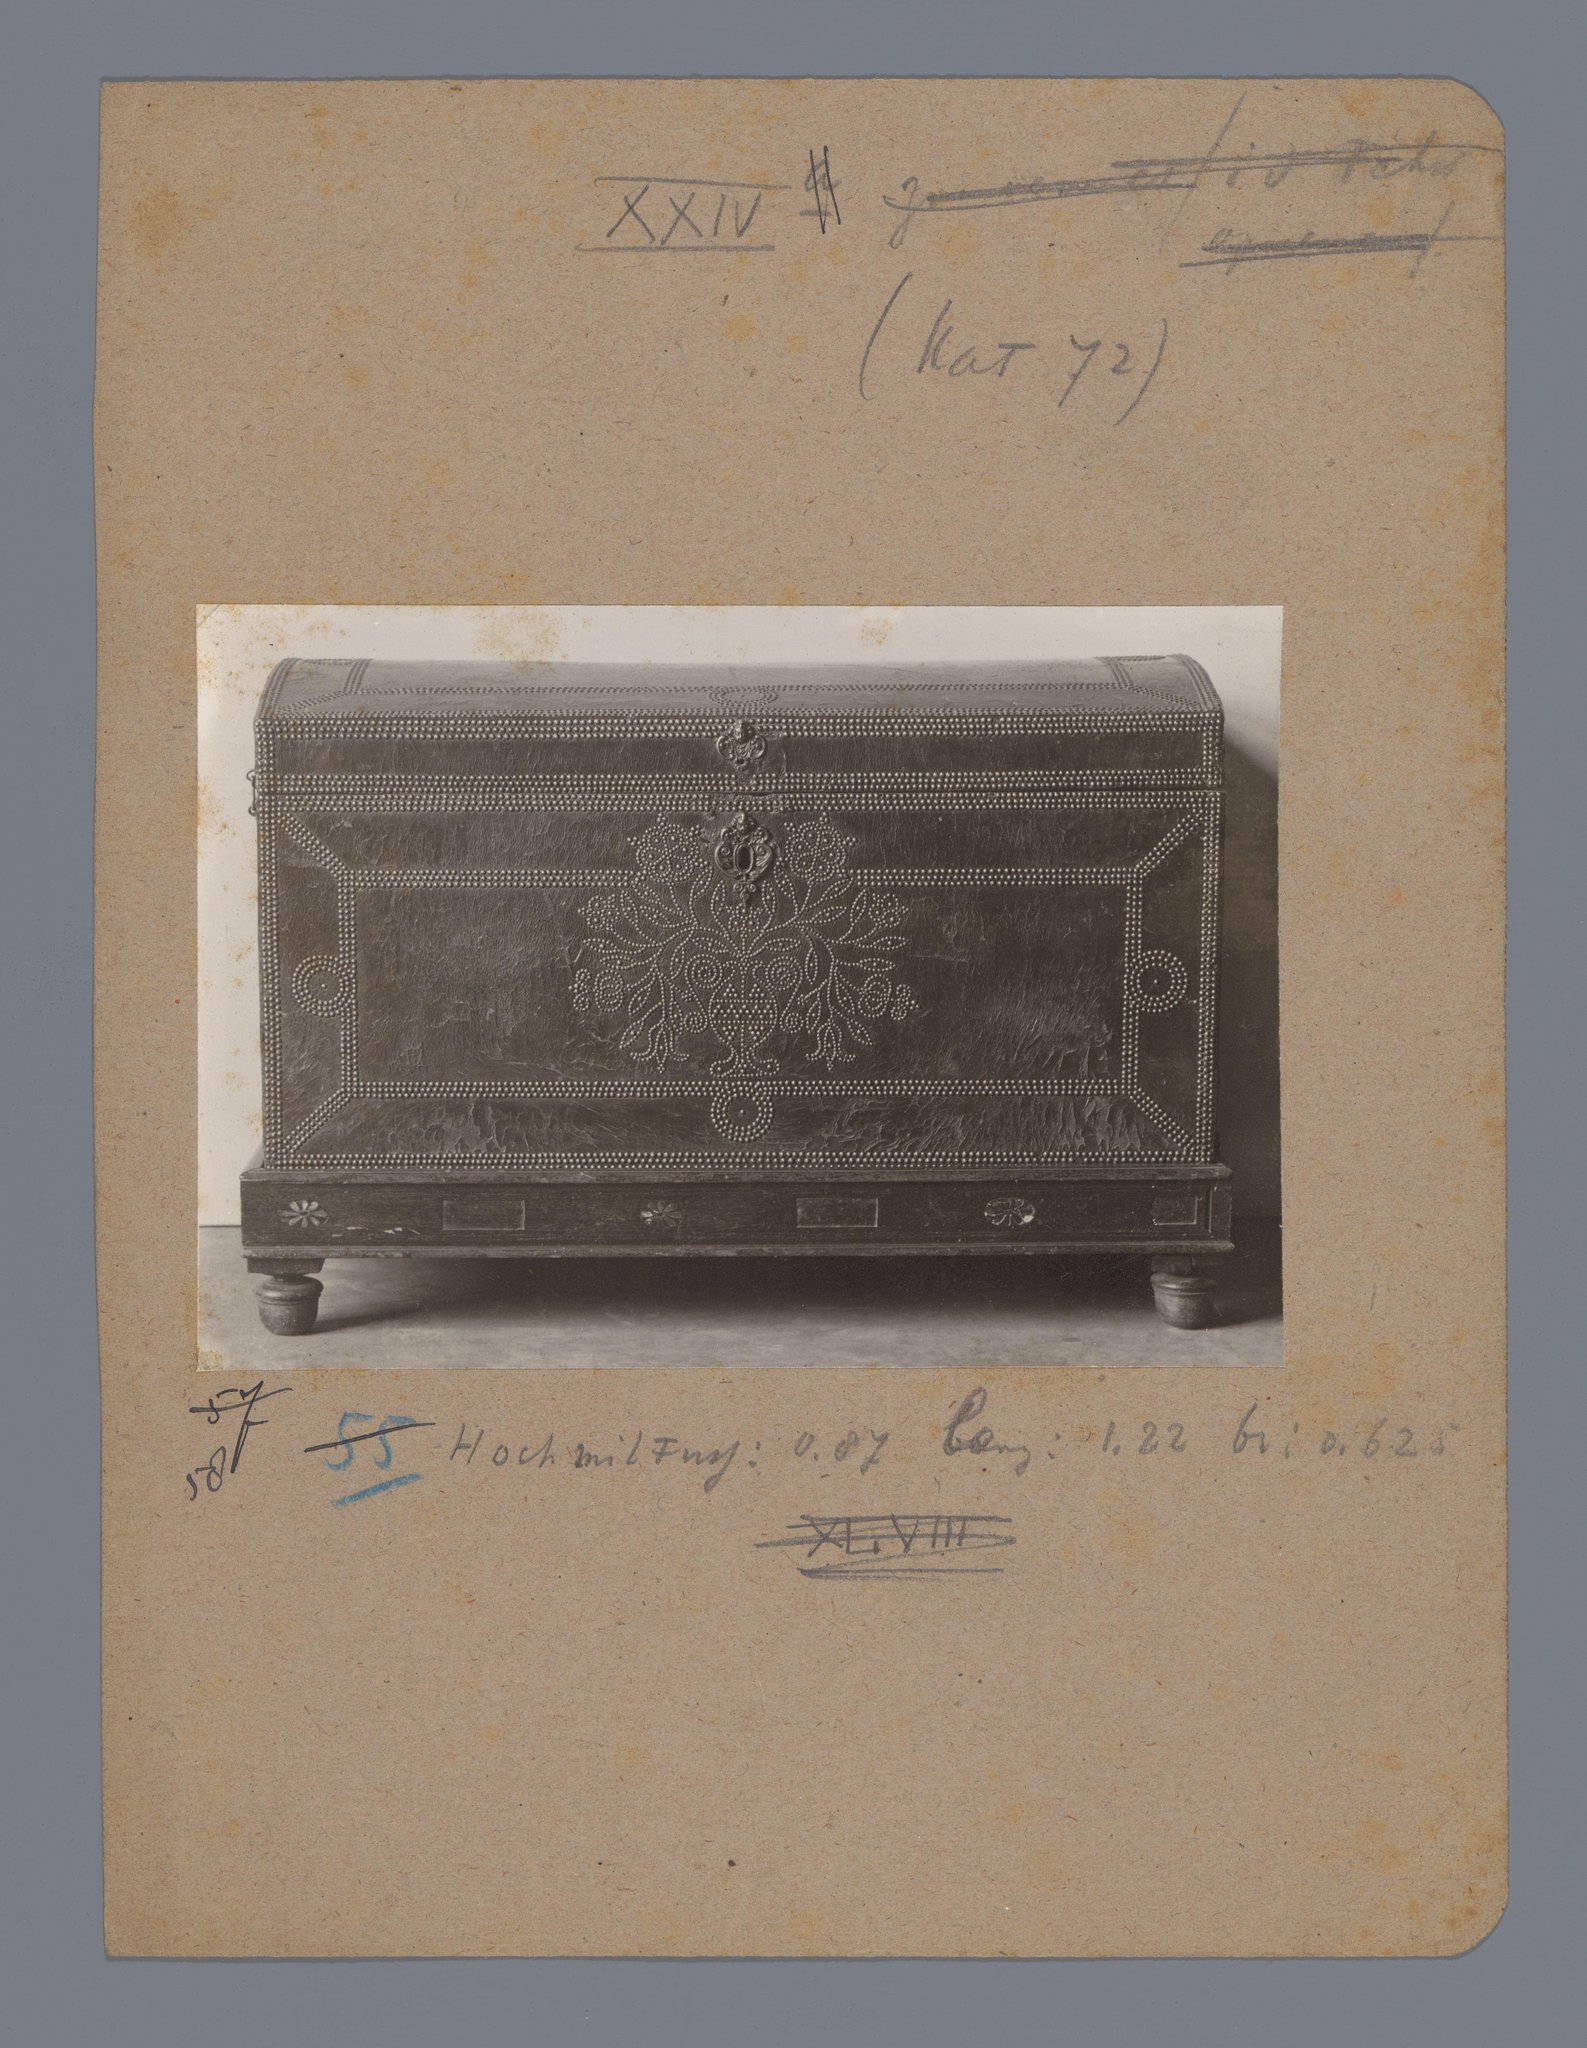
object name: photograph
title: Kist met bloemmotief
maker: Anonymous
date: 1875-1900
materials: paper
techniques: carbon print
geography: netherlands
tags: chest, coffer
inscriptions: collector's mark: ‘Kunstnijverheidschool Quellinus Amsterdam Frans Halsstraat 14.’, collector's mark: ‘Instituut voor kunst-nijverheidsonderwijs Gabriël Metsustraat No. 16, Amsterdam’, inscription: ‘Hoch mit Fug: 0, 87 lang: 1,22 bi: 0,625’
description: Voor een andere foto van dezelfde kast zie RP-F-00-8445.